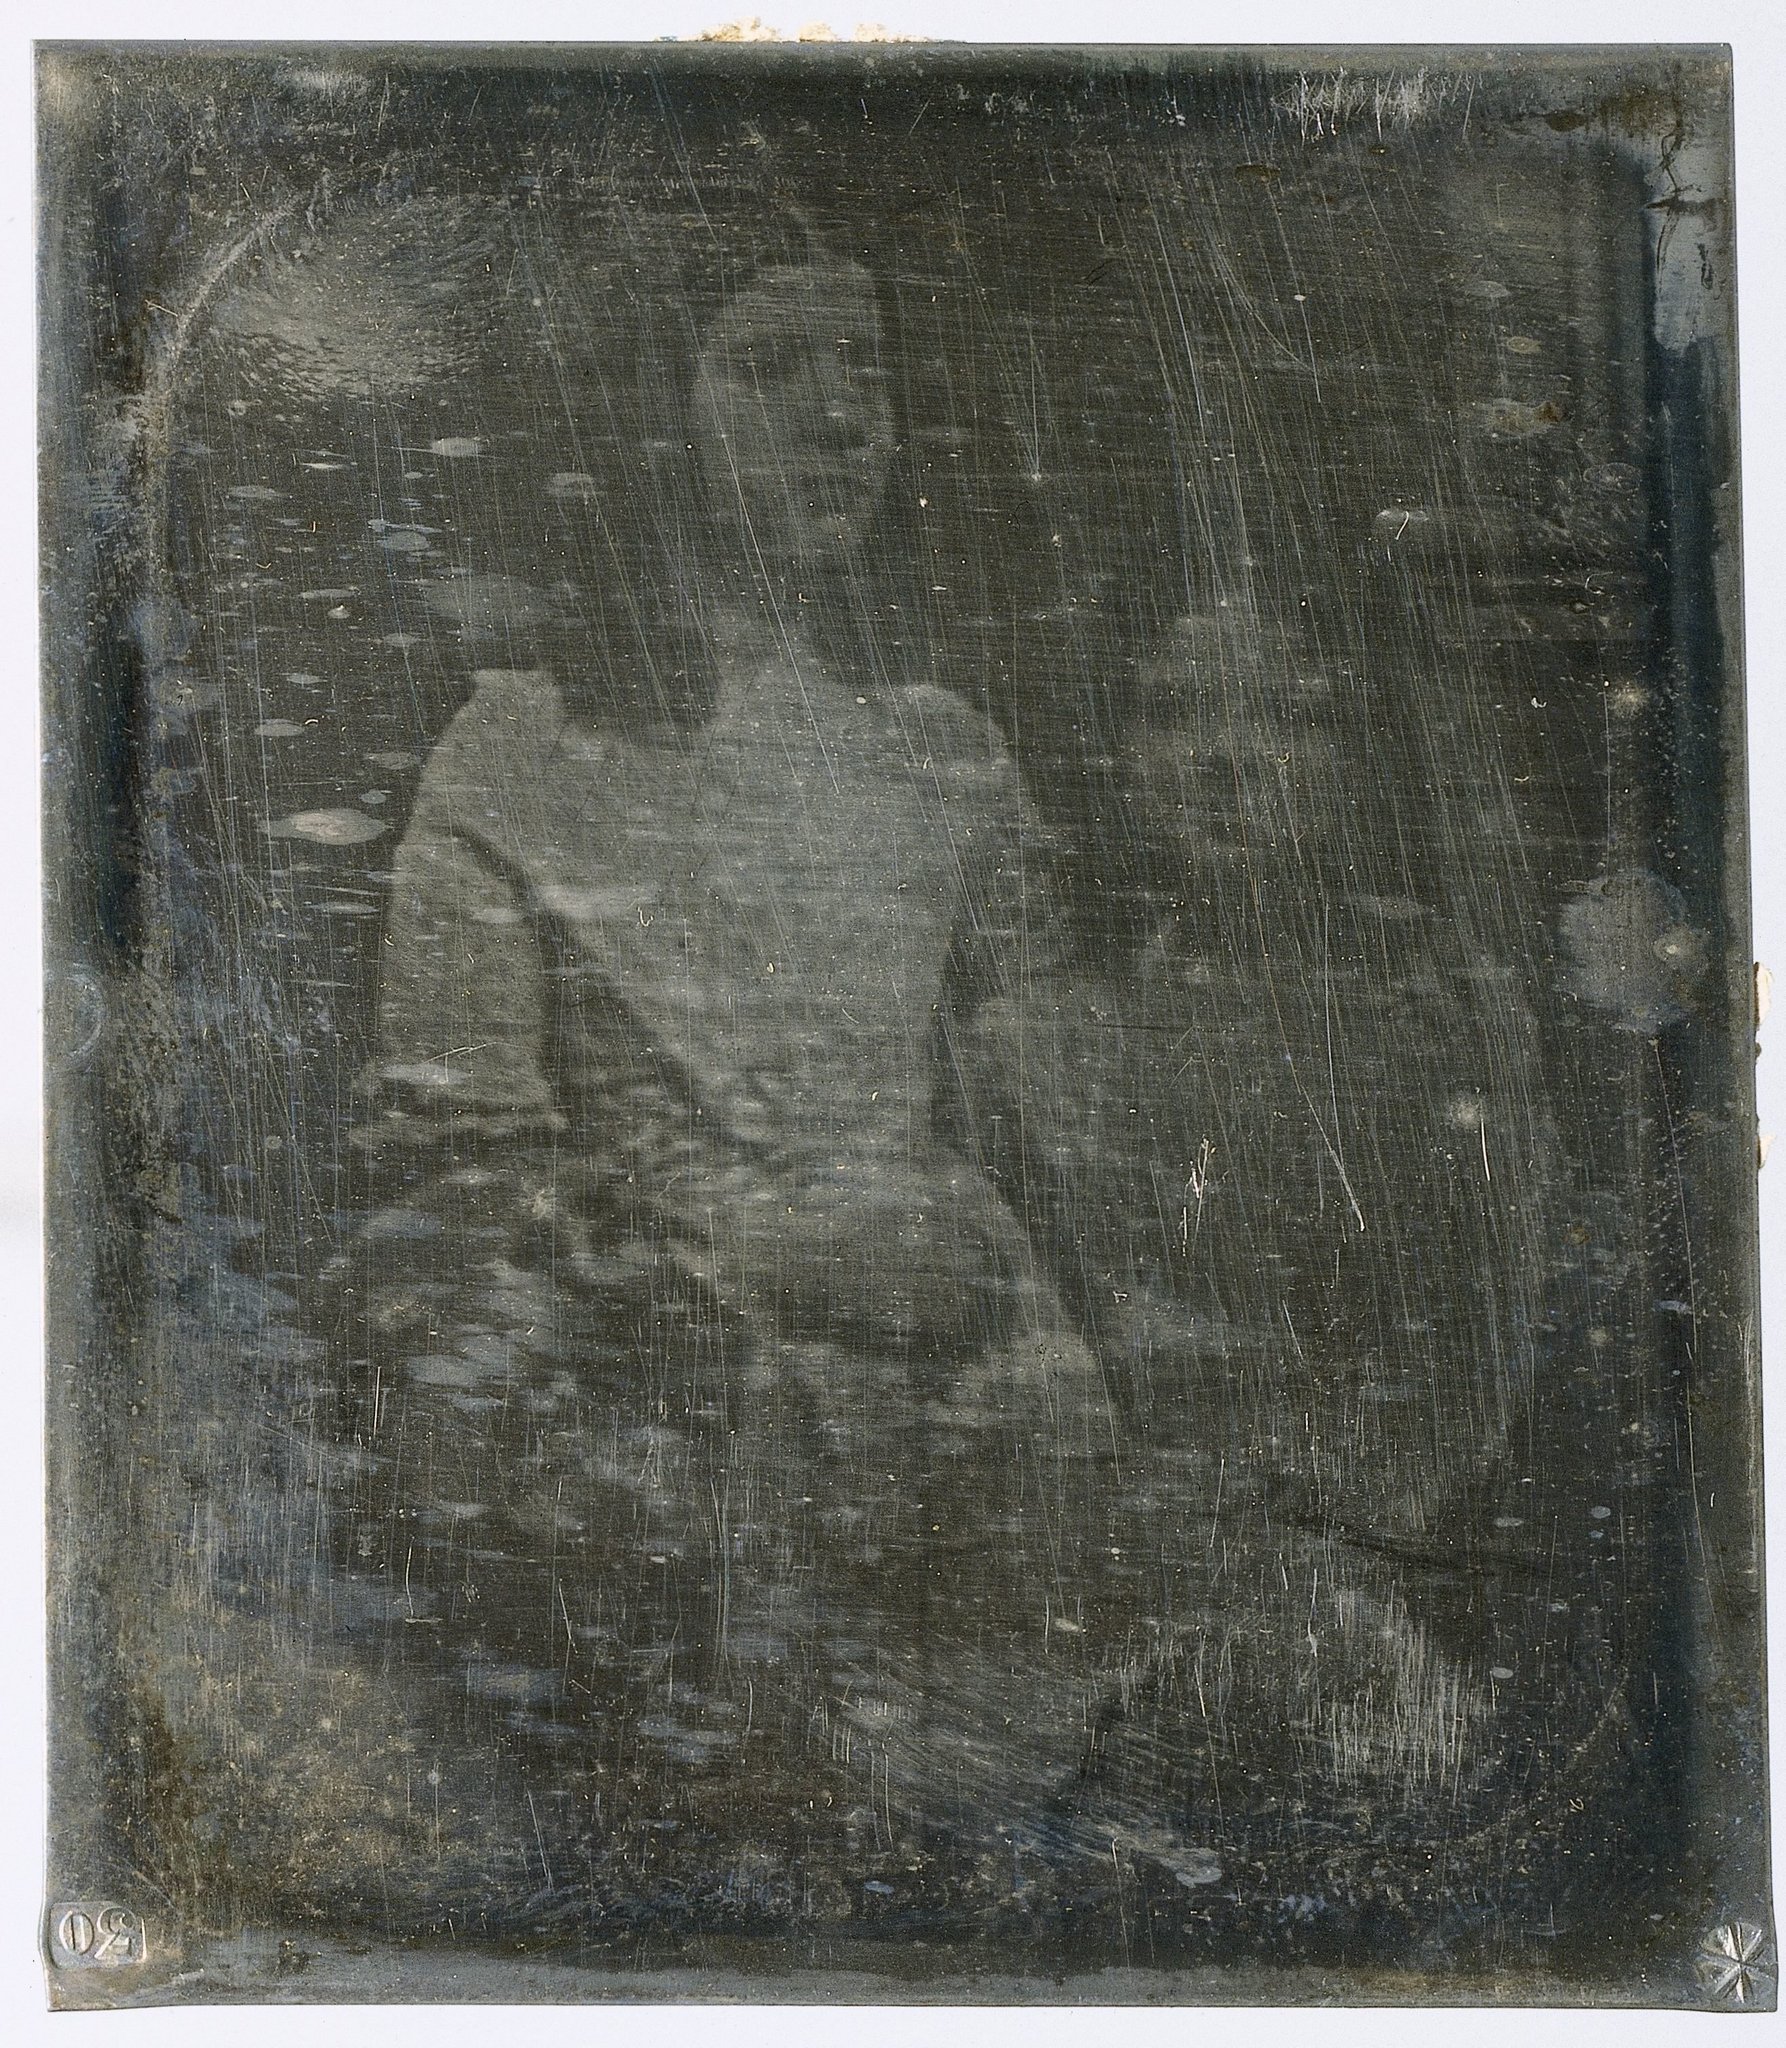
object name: photograph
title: Portret van Jeanne en Rosa Asser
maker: eduard isaac asser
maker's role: amateurfotograaf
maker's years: 1809-1894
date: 1846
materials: copper, glass, paper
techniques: daguerreotype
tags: the hague, historical persons - bb - woman, girl (child between toddler and youth)